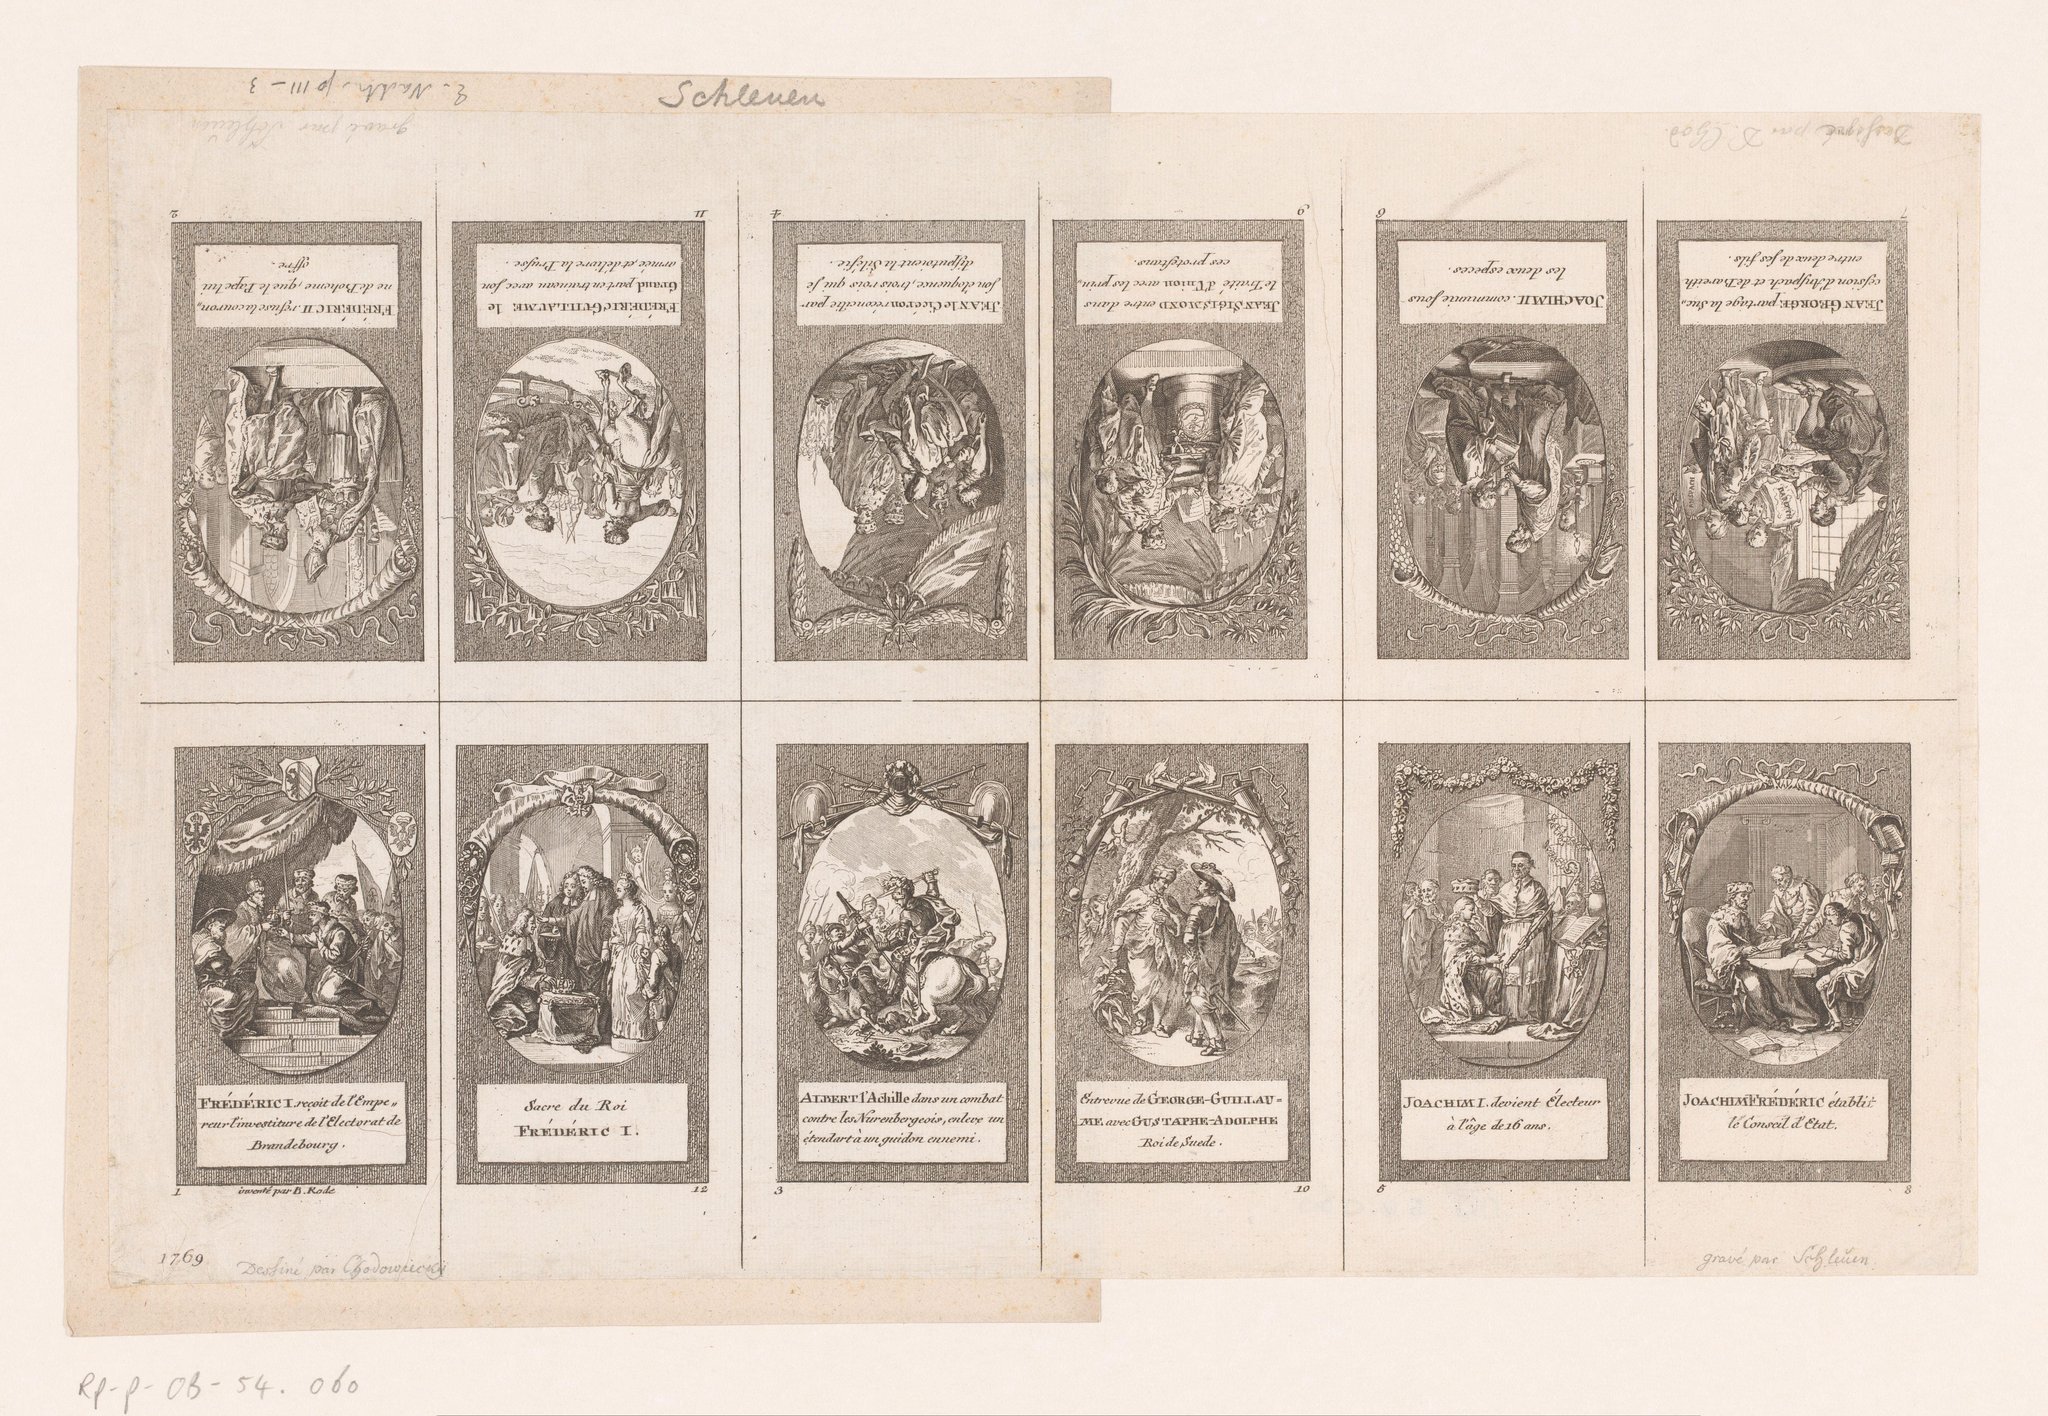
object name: print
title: Twaalf scènes uit de Brandenburgse geschiedenis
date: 1769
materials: paper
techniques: etching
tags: historical events and situations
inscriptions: name, collector's mark: Lugt 2228